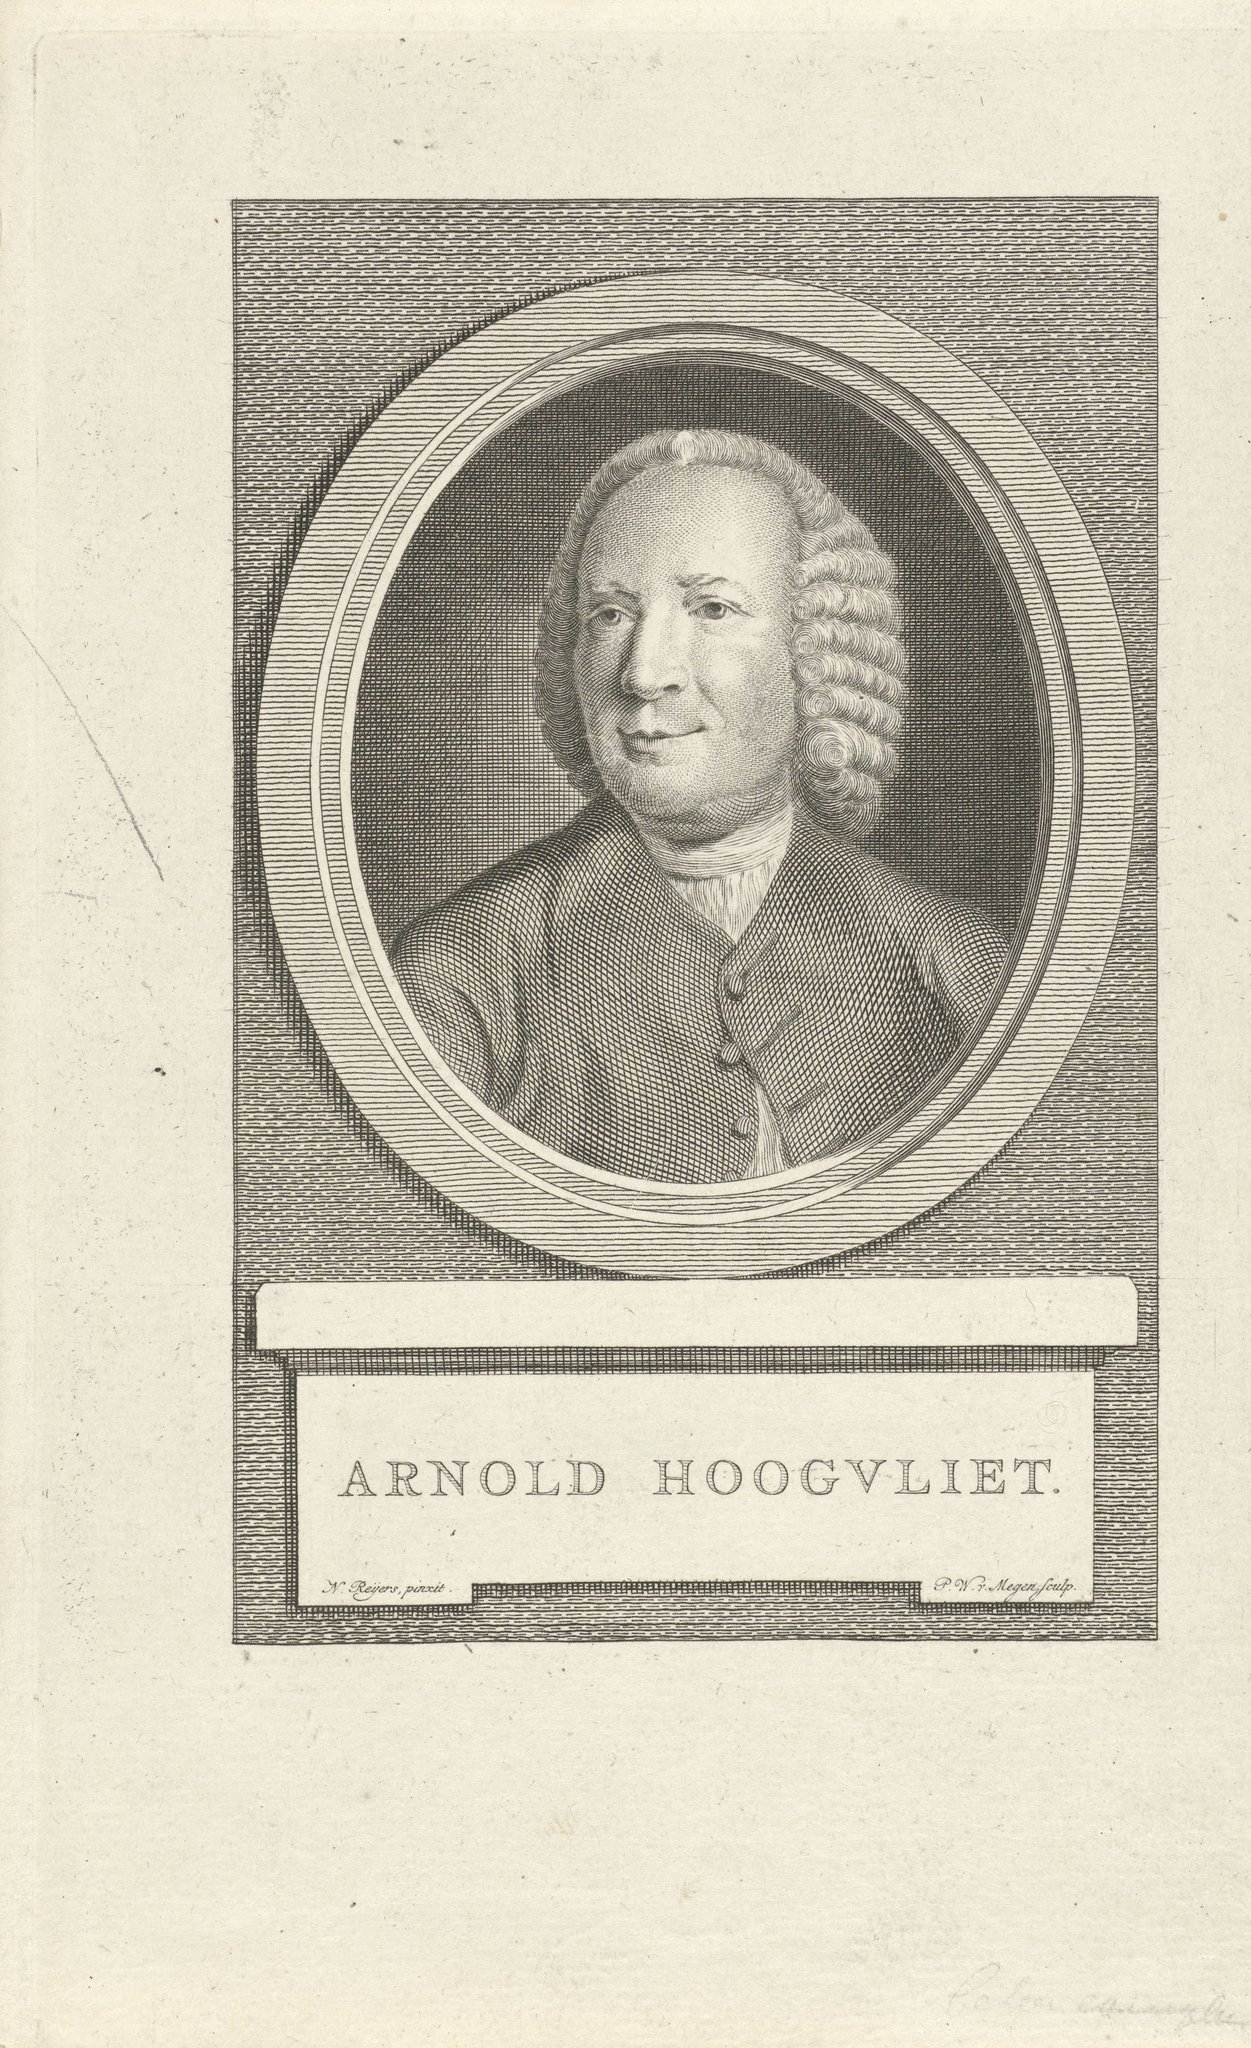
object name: print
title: Portret van Arnold Hoogvliet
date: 1760-1785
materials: paper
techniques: engraving, etching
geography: the hague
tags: arnold hoogvliet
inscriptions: inscription: ‘Pecker’, collector's mark: Lugt 2228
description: Portret van de dichter Arnold Hoogvliet in een ovale lijst.